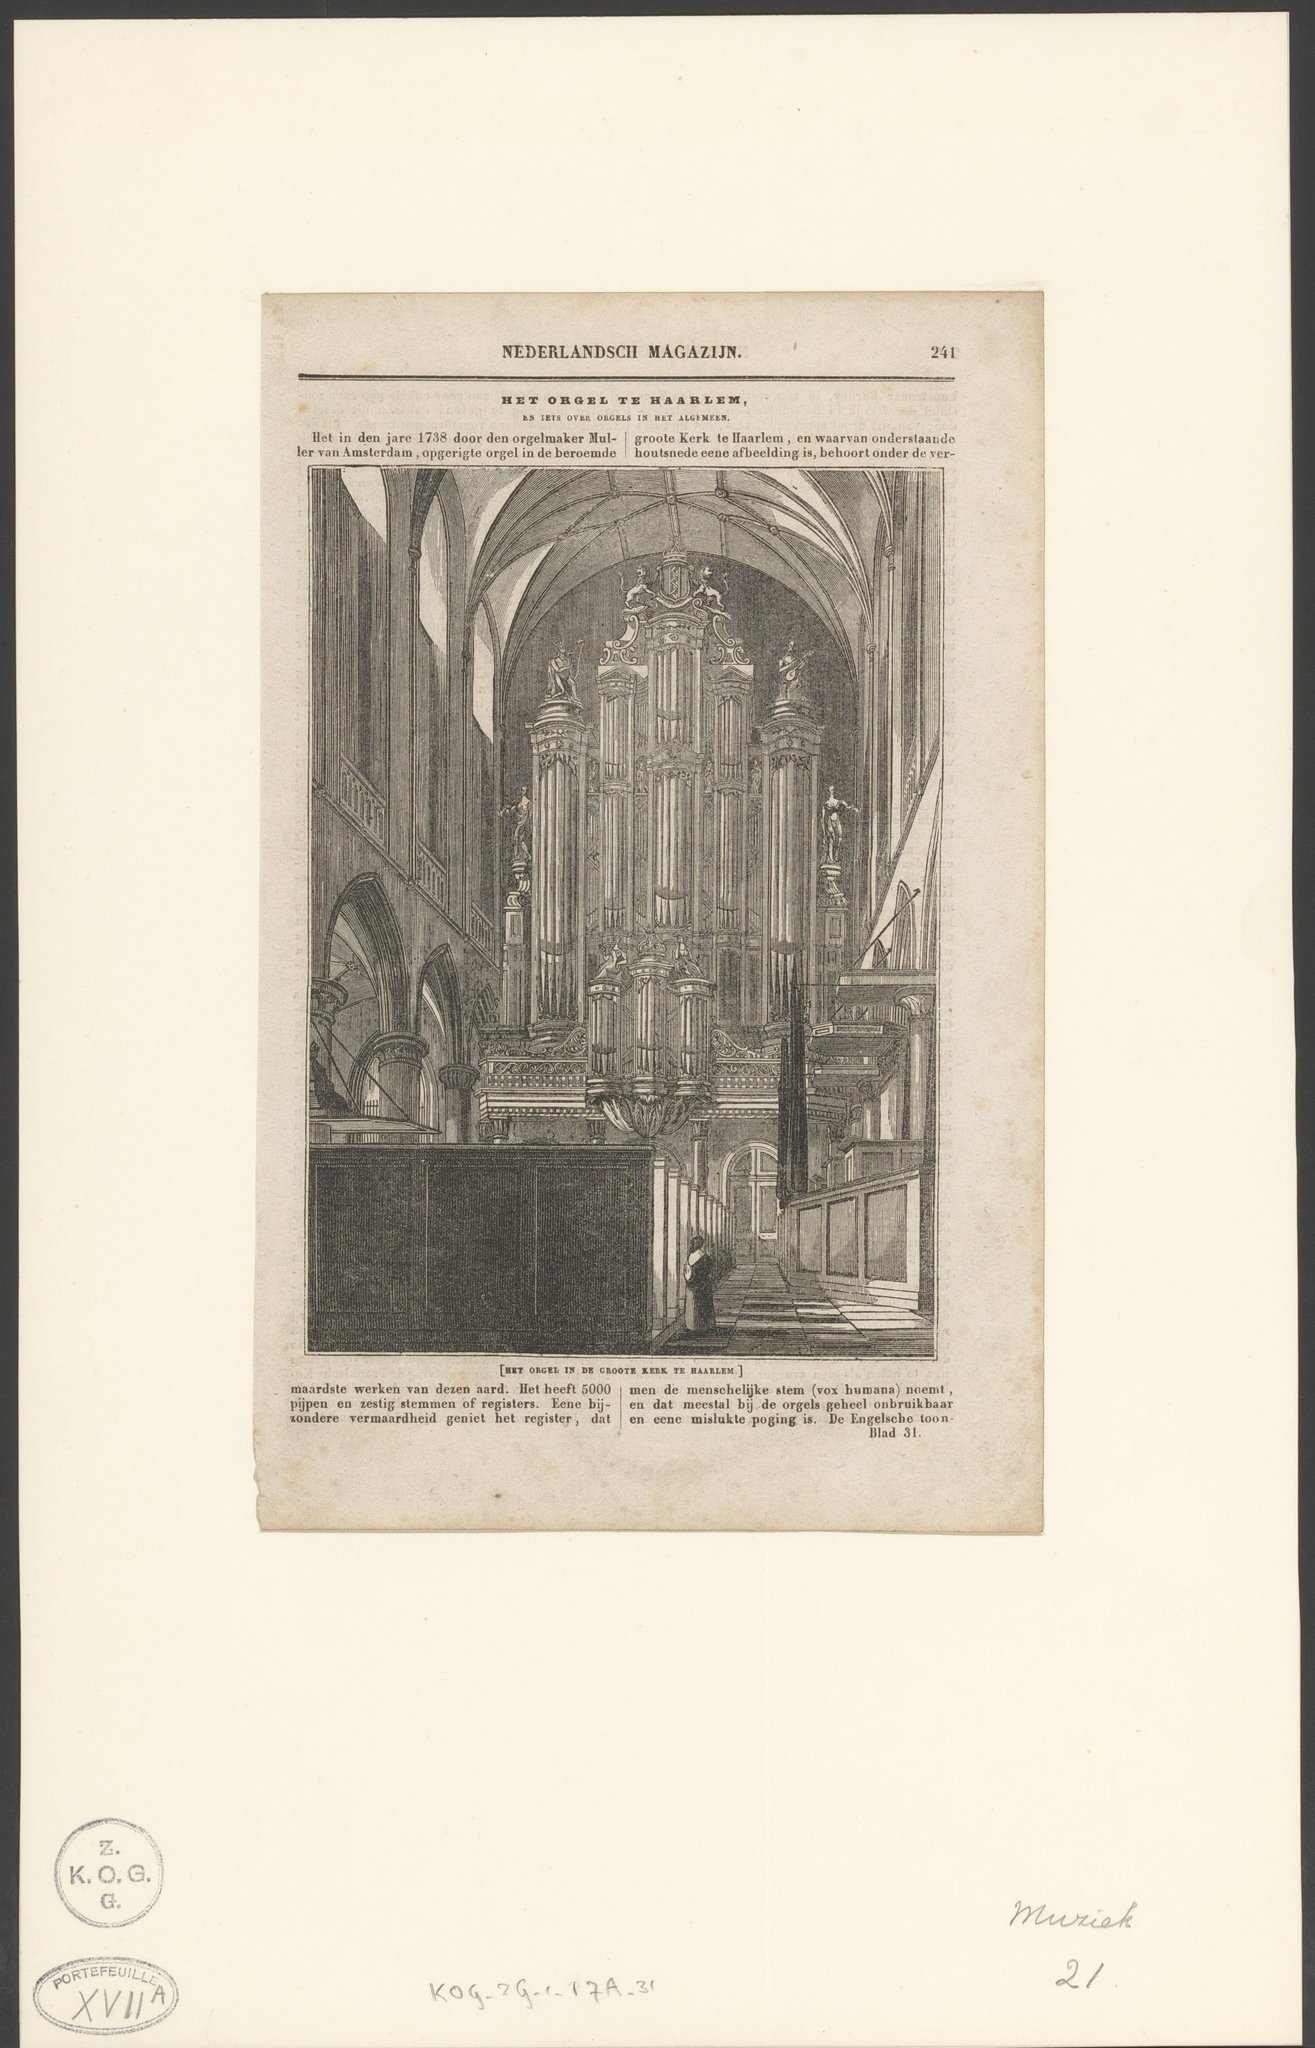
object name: print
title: Het orgel te Haarlem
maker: Anonymous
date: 1865-1885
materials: paper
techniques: engraving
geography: netherlands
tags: church organ, interior of church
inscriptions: collector's mark: Lugt 1641, stamp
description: Kerkinterieur met gezicht op het orgel in de Grote Kerk of Sint Bavo te Haarlem. Bedrukt op beide zijden met tekst. Genomen uit een aflevering van het 'Nederlandsch Magazijn'. Onderwerpsrubrieken binnen de Atlas Zeden en Gewoonten: Muziek en muziekinstrumenten: Kerkorgels.